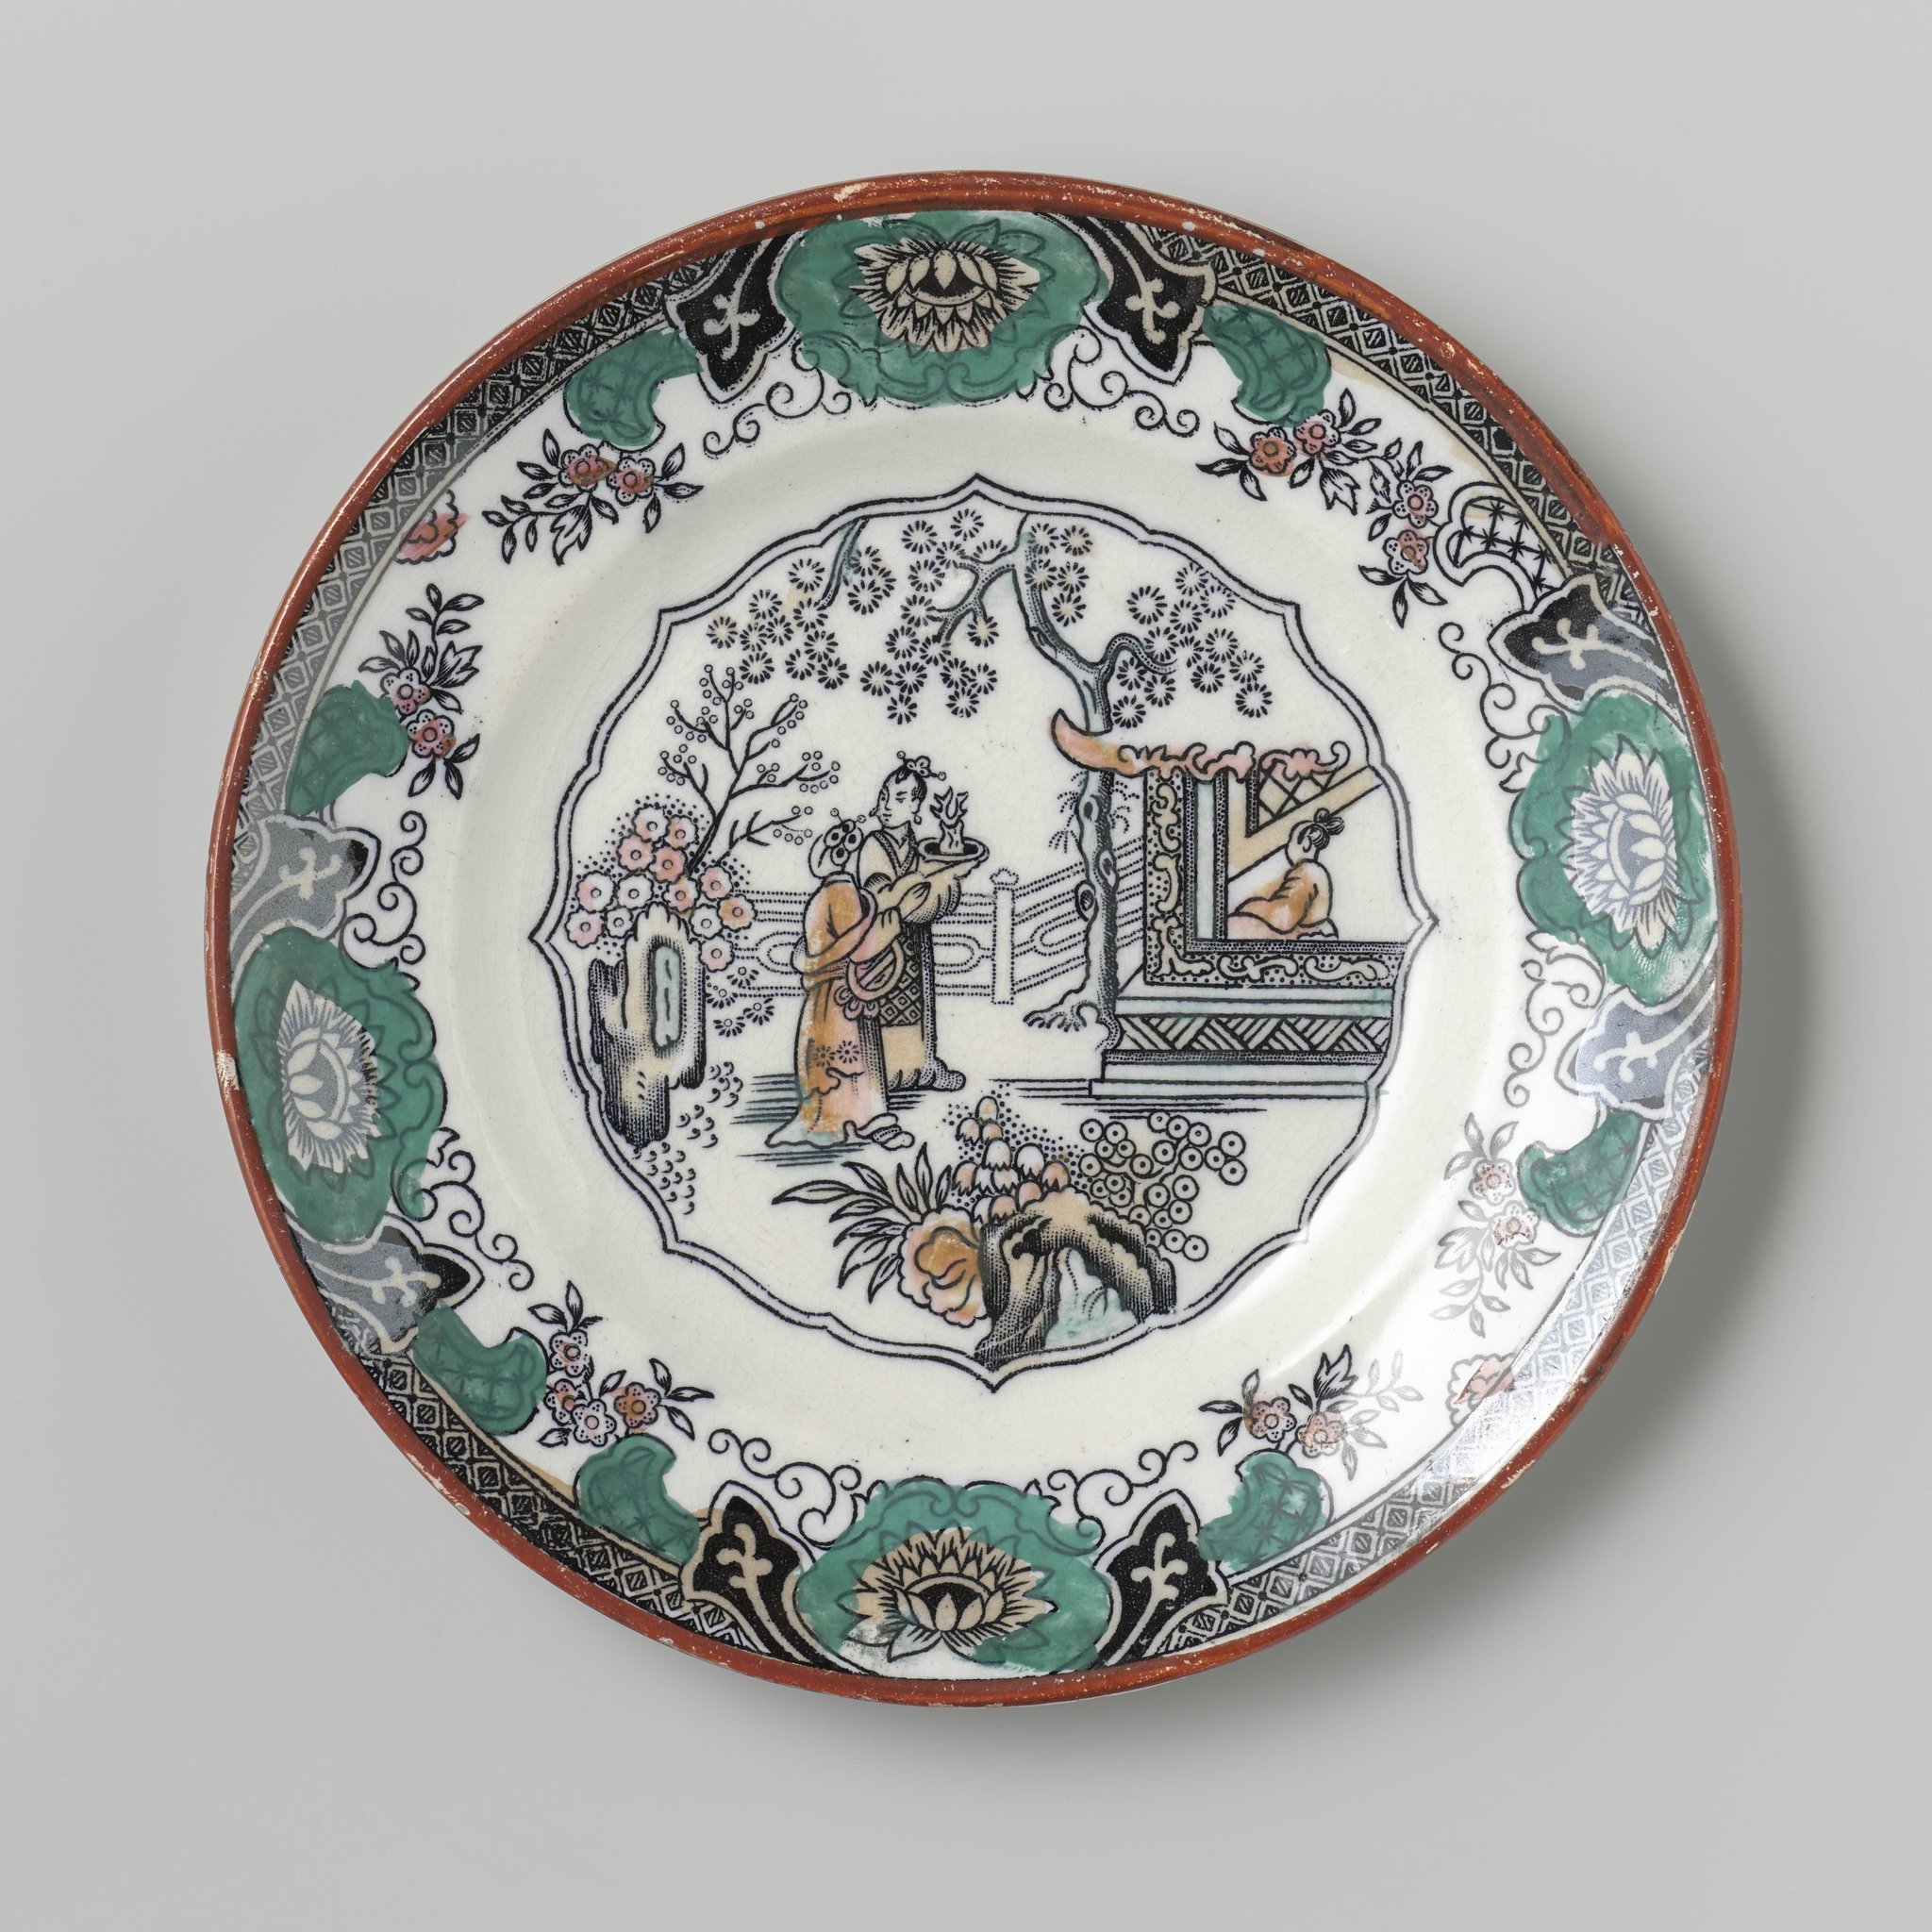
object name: plate dish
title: Bord met op het plat een huis met een tuin, waarin twee vrouwen lopen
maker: Anonymous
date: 1400-1950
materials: earthenware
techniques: muffling, transfer decoration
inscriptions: mark: ‘L X’, mark: ‘CHINOIS // FAIENCERIE // JEMAPPES’, check stamp: ‘FAIENCERIE DE JEMAPPES’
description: Bord van aardewerk met zwart transferdecor en moffelkleuren. Op het plat een een huis met een tuin, waarin twee vrouwen lopen. Voor het venster van het huis zit nog een gestalte.